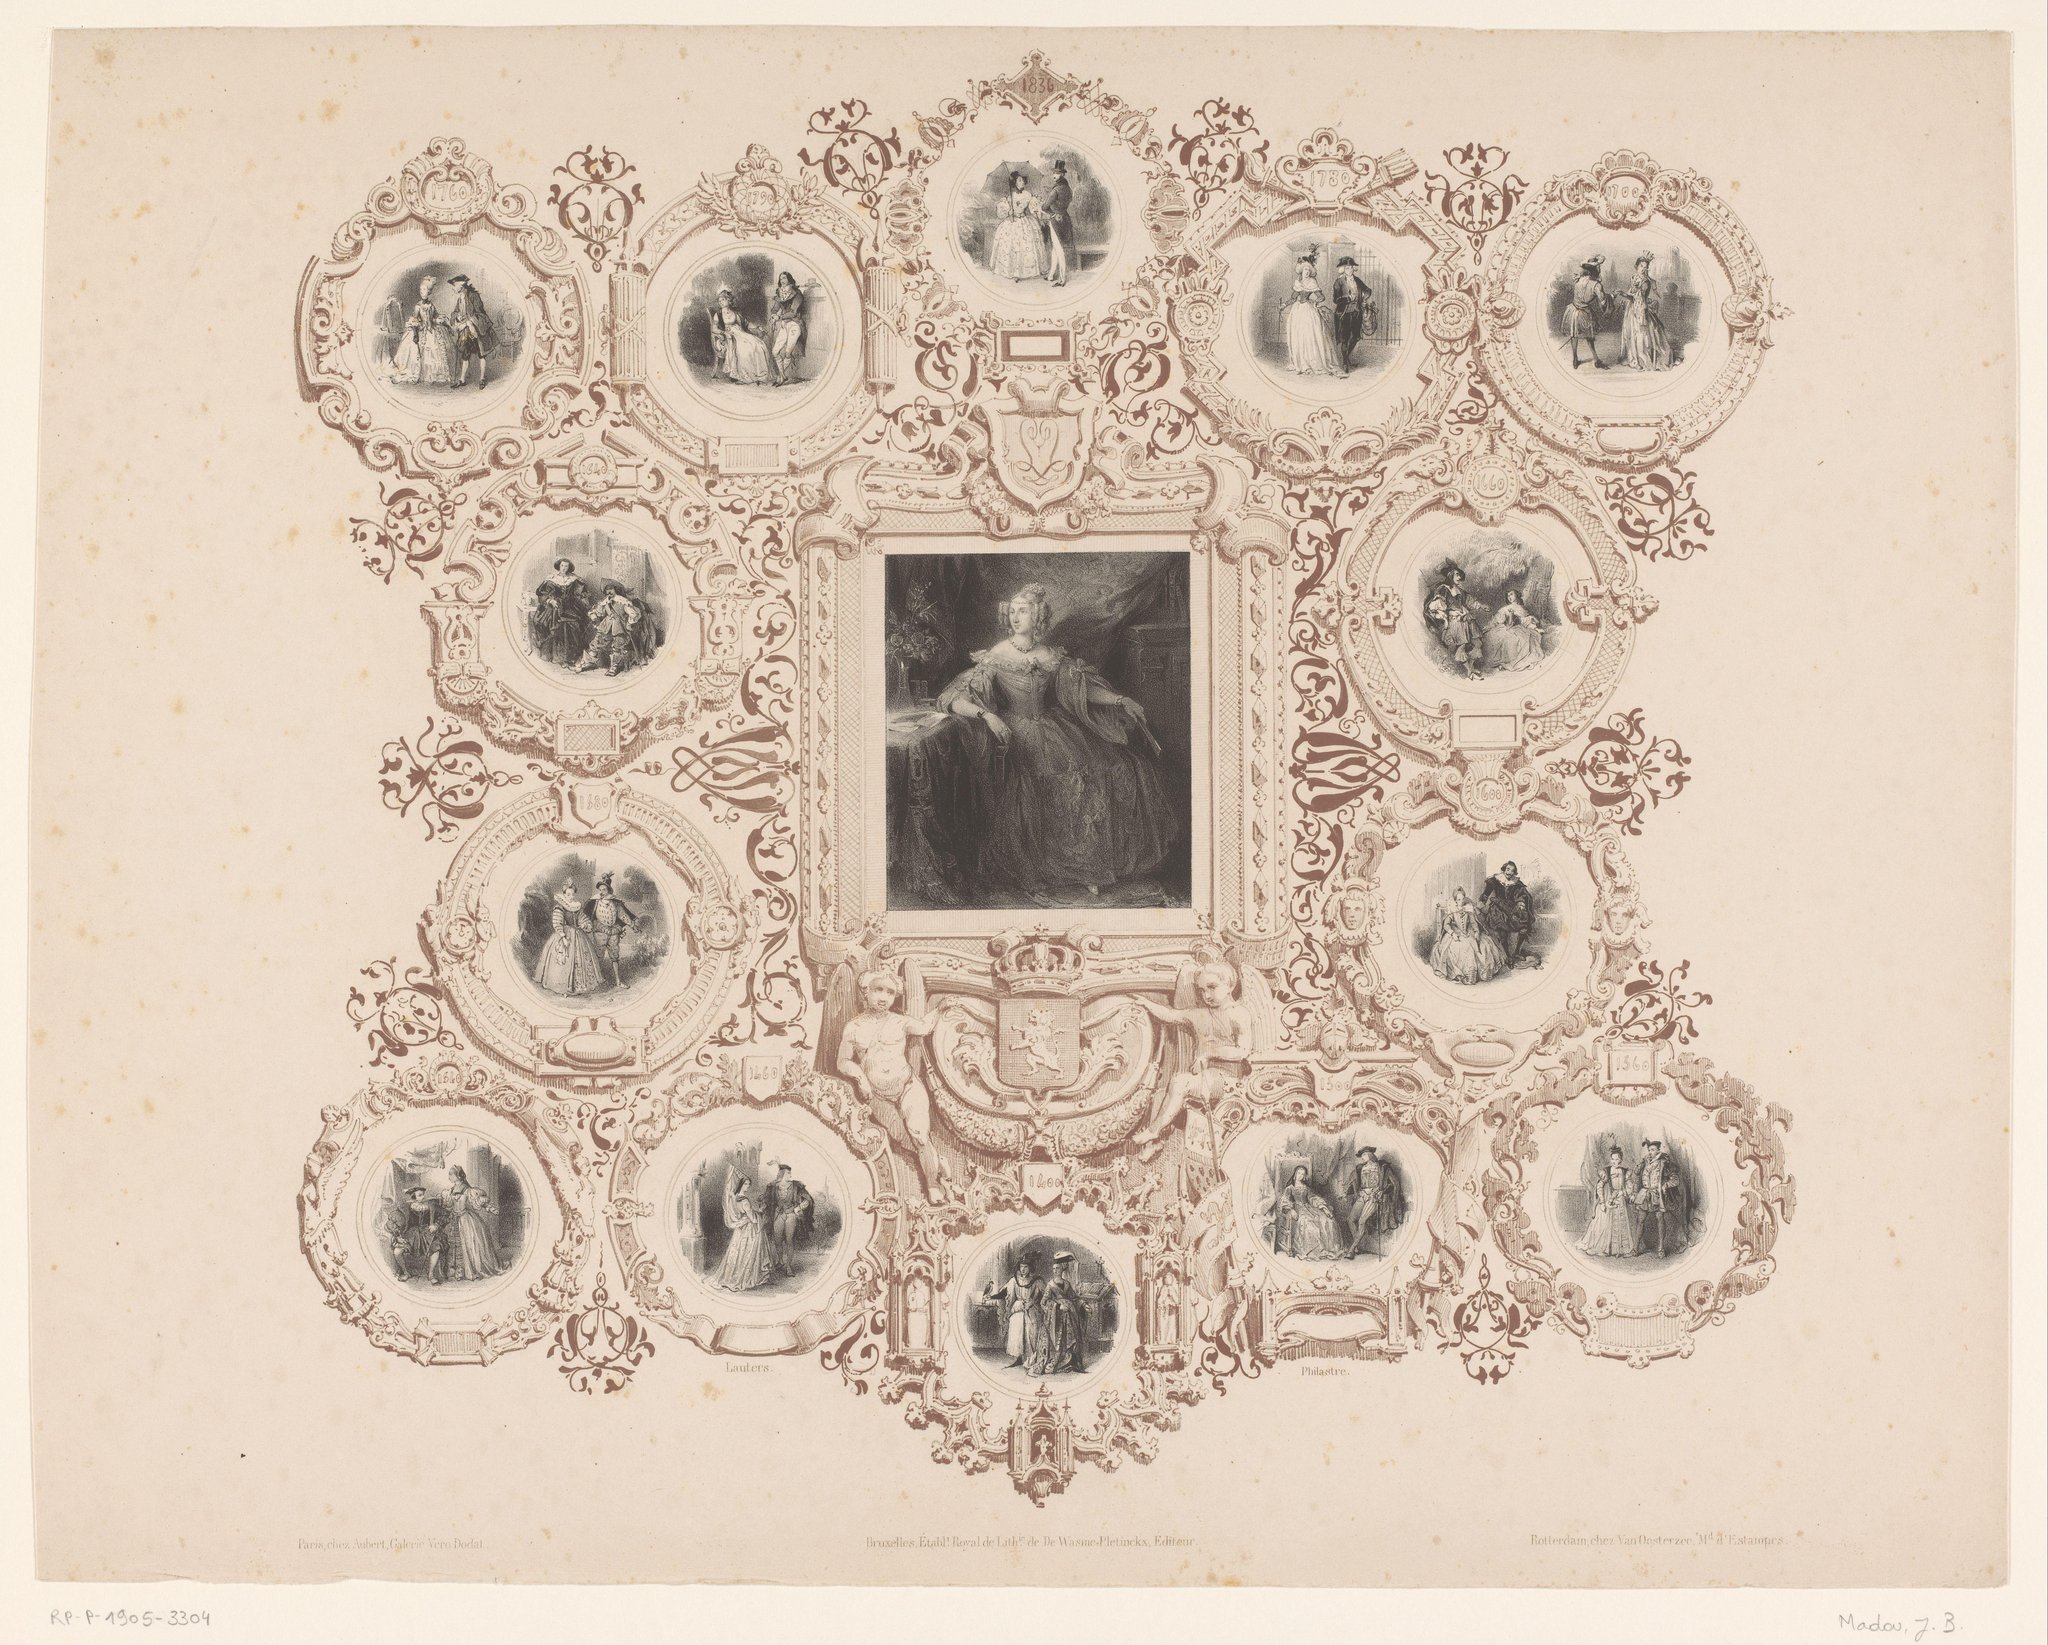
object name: print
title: Portret van Louise Marie van Orléans met ornamentele omlijsting met diverse voorstellingen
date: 1836-1837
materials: paper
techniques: lithograph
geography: rotterdam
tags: louise marie van orléans (koningin van belgië), adult woman, historical persons, historical costume, couple of lovers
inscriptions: collector's mark: Lugt 2228